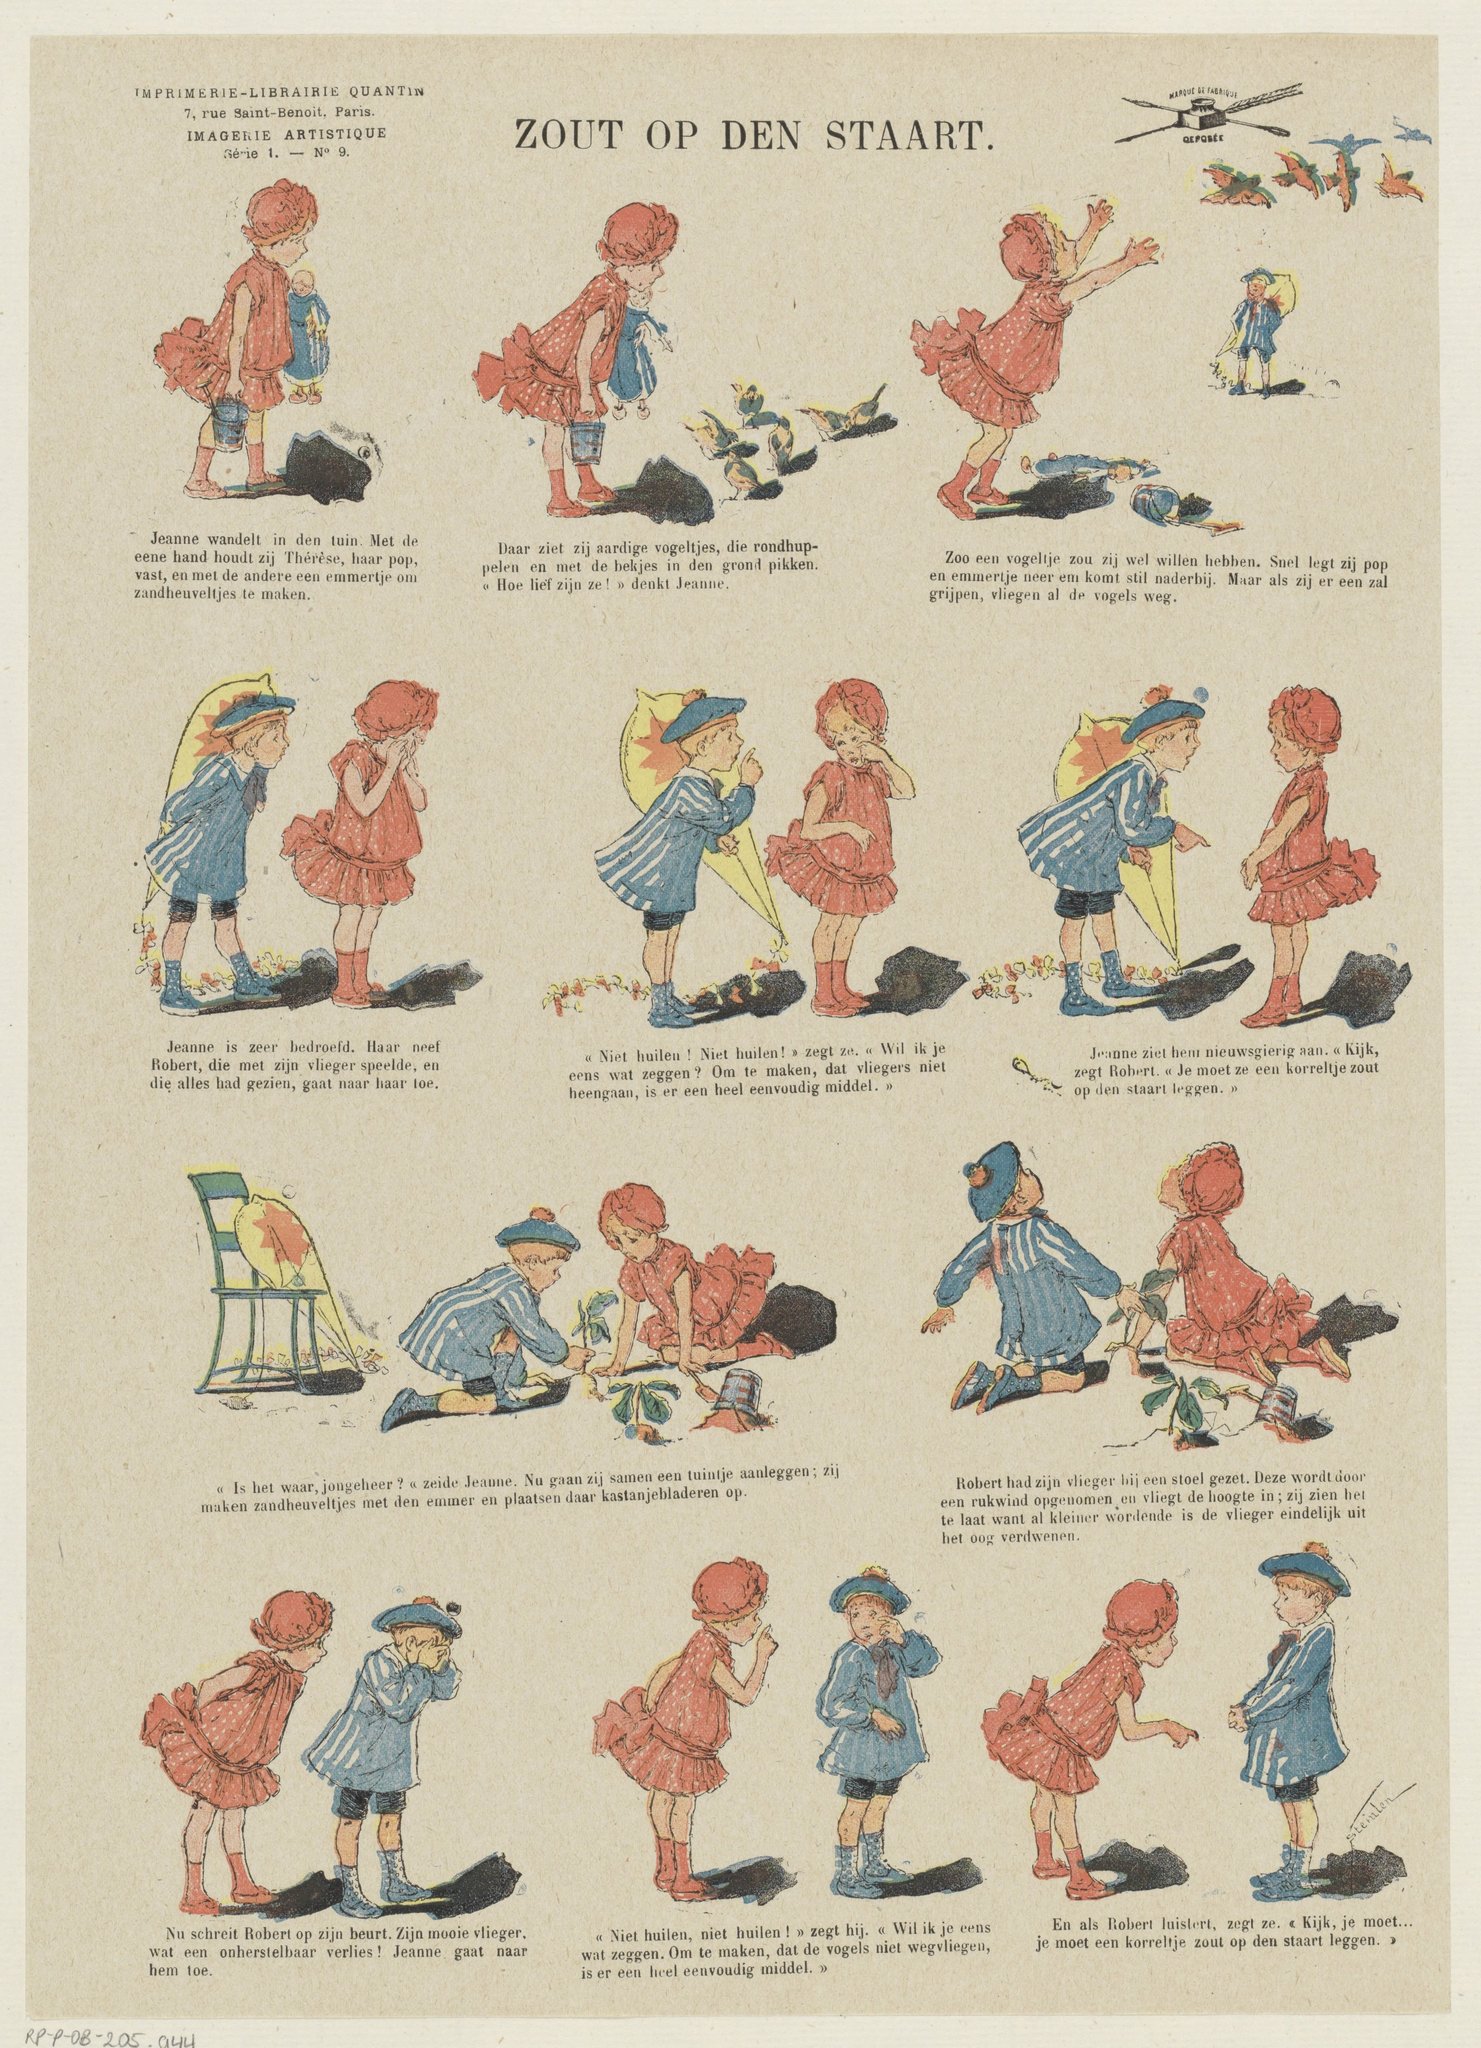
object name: popular print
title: De zwarte vlek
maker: albert quantin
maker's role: printer, publisher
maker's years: 1850-1933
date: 1876-1890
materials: paper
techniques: lithograph, letterpress printing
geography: paris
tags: children's games and plays, tales and fairy tales, (flying a) kite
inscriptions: collector's mark: Lugt 2760, : ‘marque de fabrique / deposée’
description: Blad met 11 voorstellingen van Jeanne en Robert die samen spelen. Onder elke voorstelling een onderschrift. Genummerd linksboven: Série 1. - No. 9.